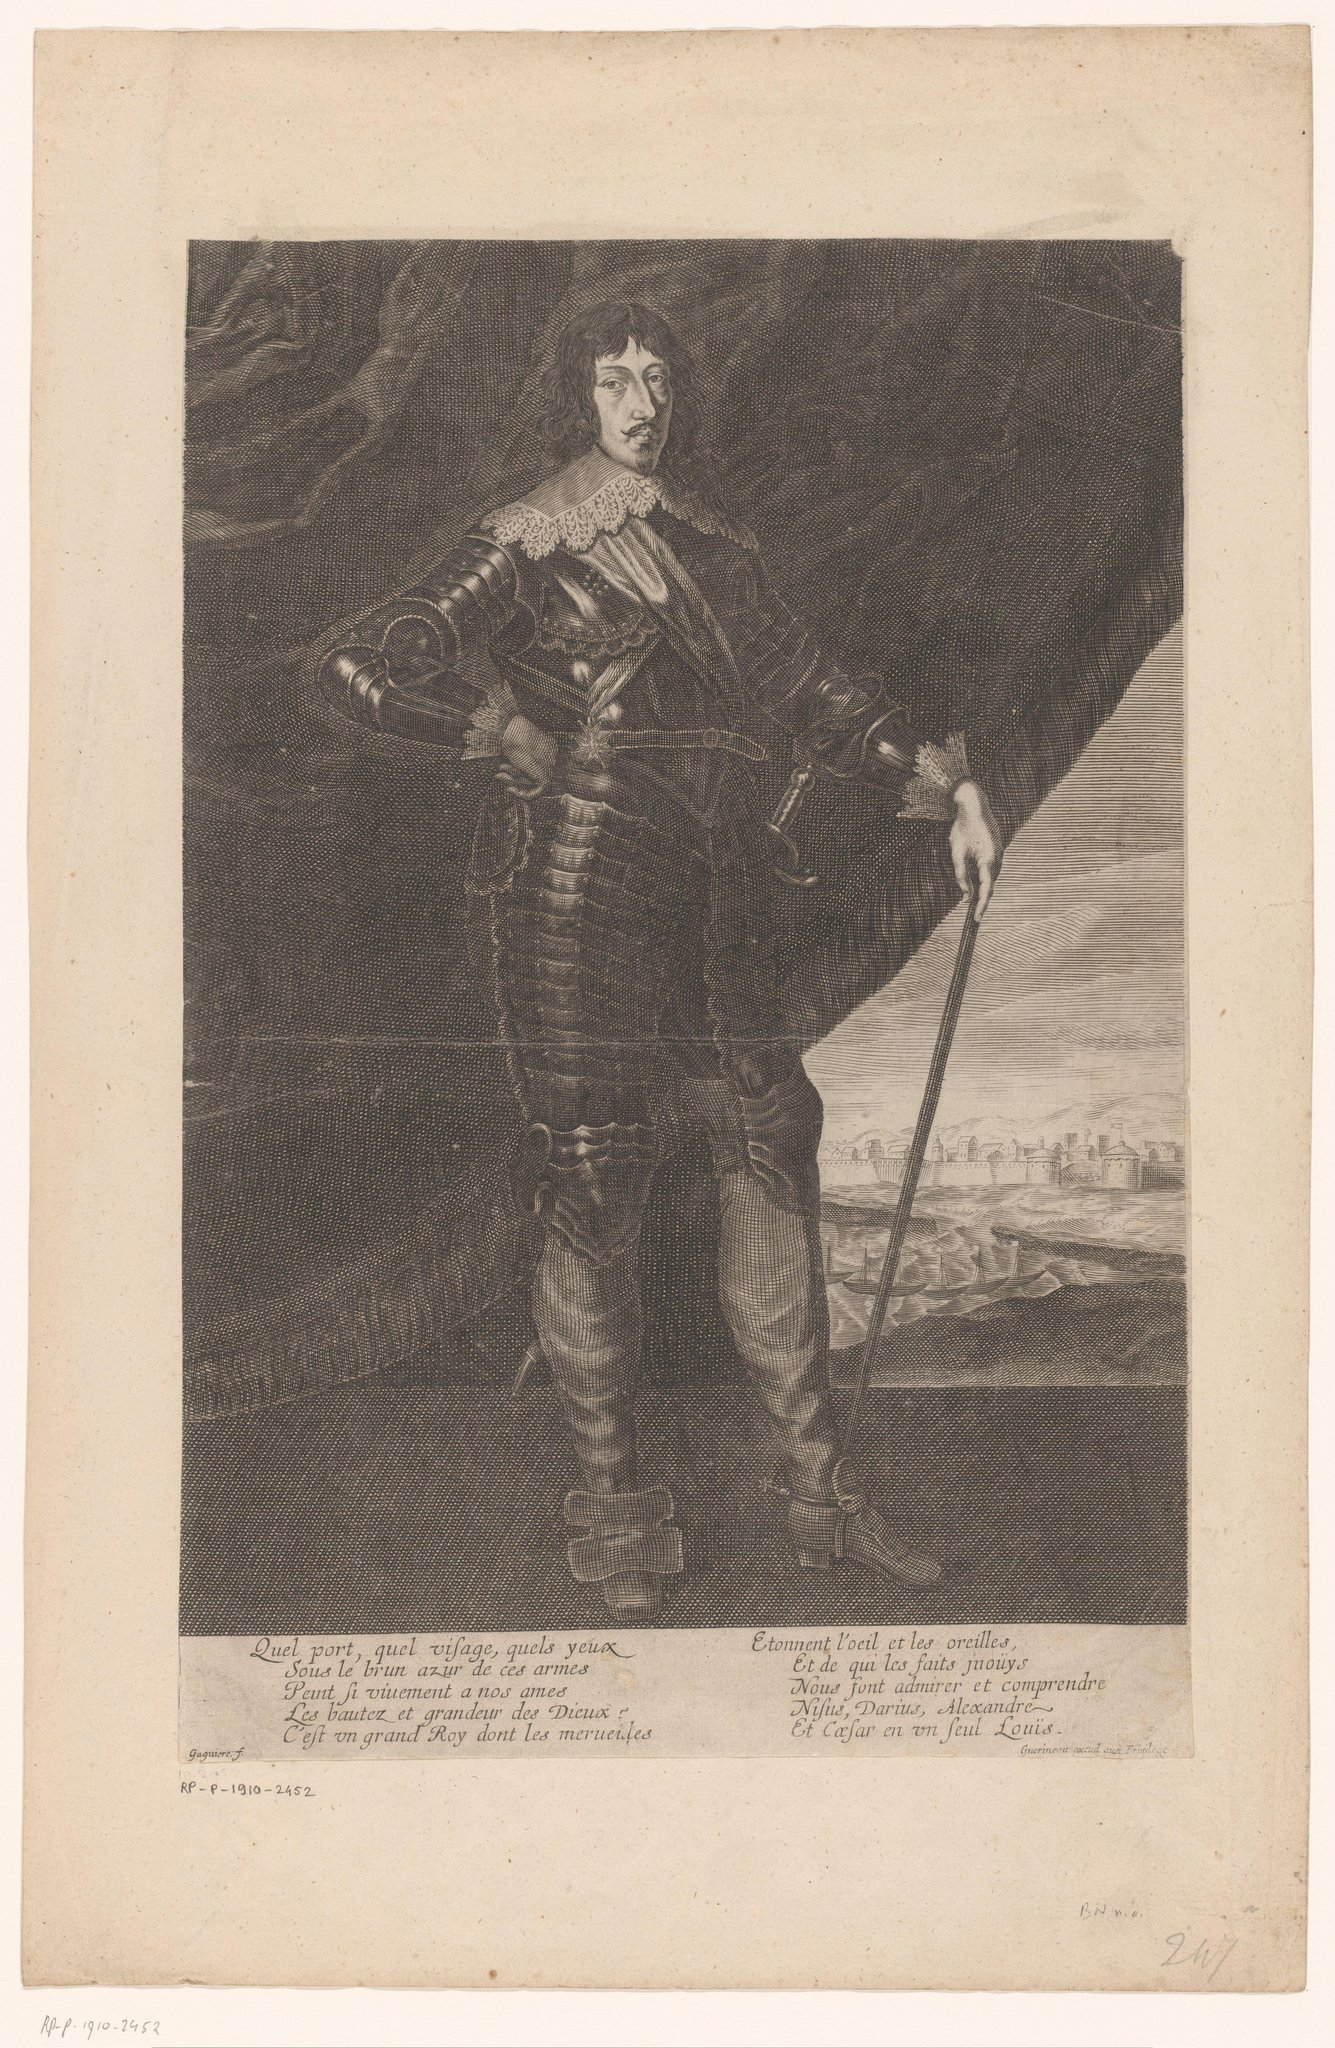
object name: print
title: Portret van Lodewijk XIV, koning van Frankrijk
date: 1625-1664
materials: paper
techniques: engraving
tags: lodewijk xiv (koning van frankrijk), historical persons, king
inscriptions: collector's mark: Lugt 2228